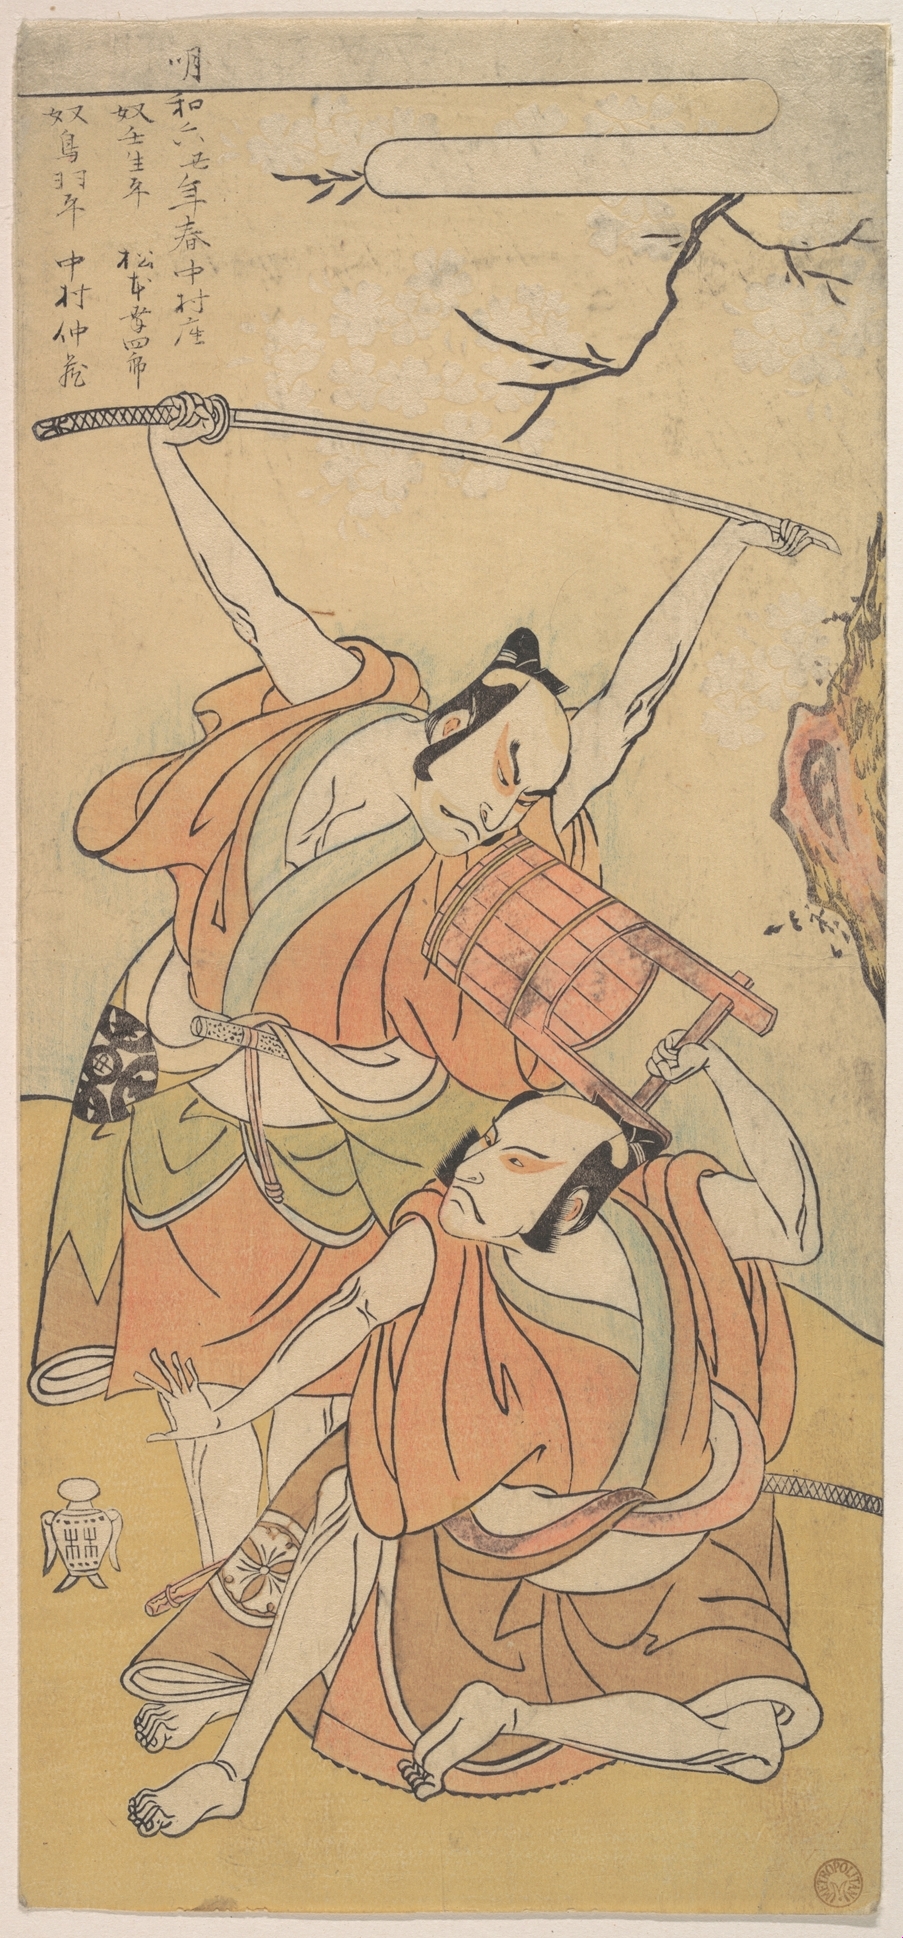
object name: woodblock print nishiki e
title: The First Nakamura Nakazo as the Yakko (Servant) Tobahei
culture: japanese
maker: katsukawa shunshō 勝川春章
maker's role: artist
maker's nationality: japanese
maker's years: 1726-1792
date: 1769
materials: ink, paper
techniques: nishiki e, woodblock print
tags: swords,men,actors